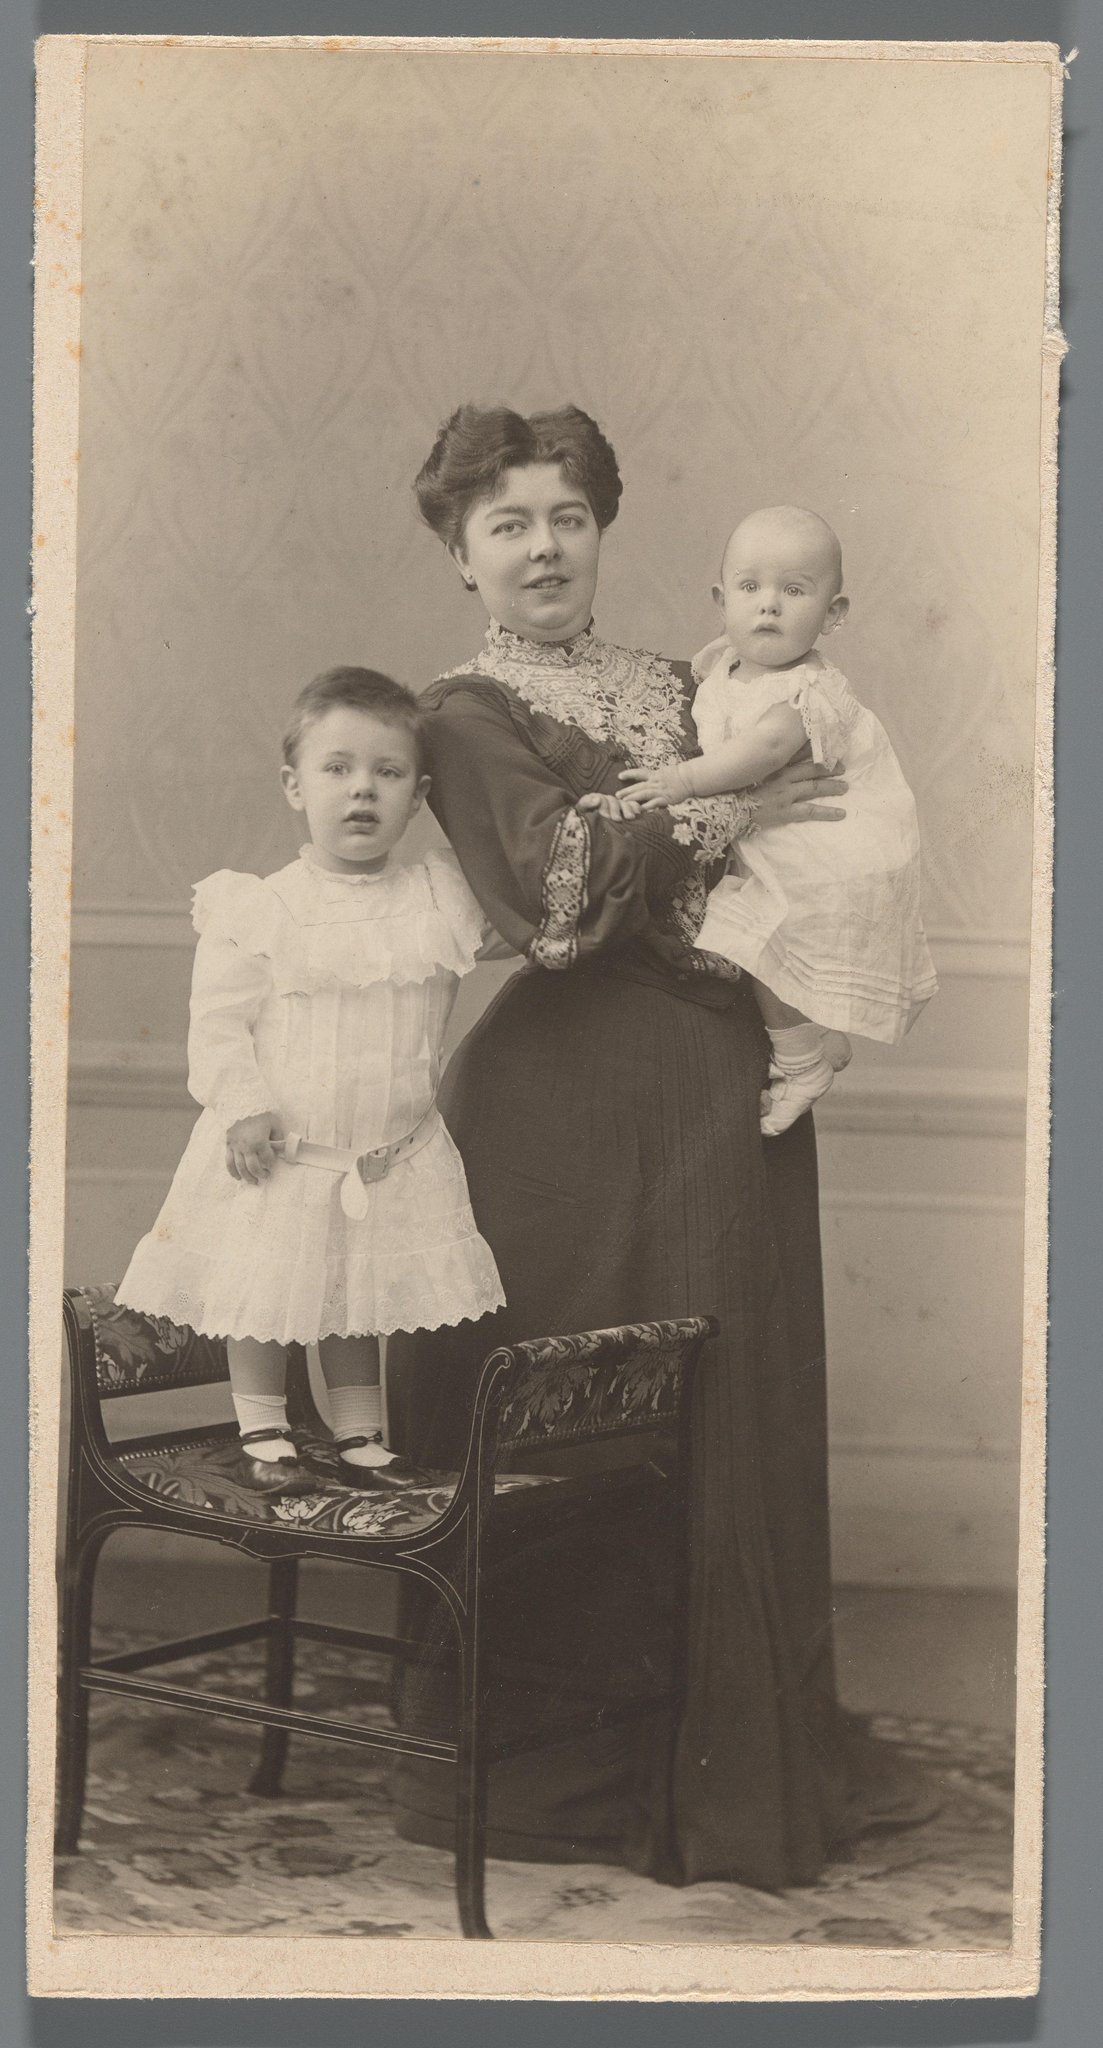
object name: photograph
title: A.C.M. Geertsema met twee jonge kinderen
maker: Anonymous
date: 1900-1920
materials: cardboard, photographic support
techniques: albumen print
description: Staande vrouw met in haar armen een baby en naast haar een staand kind op een kruk.